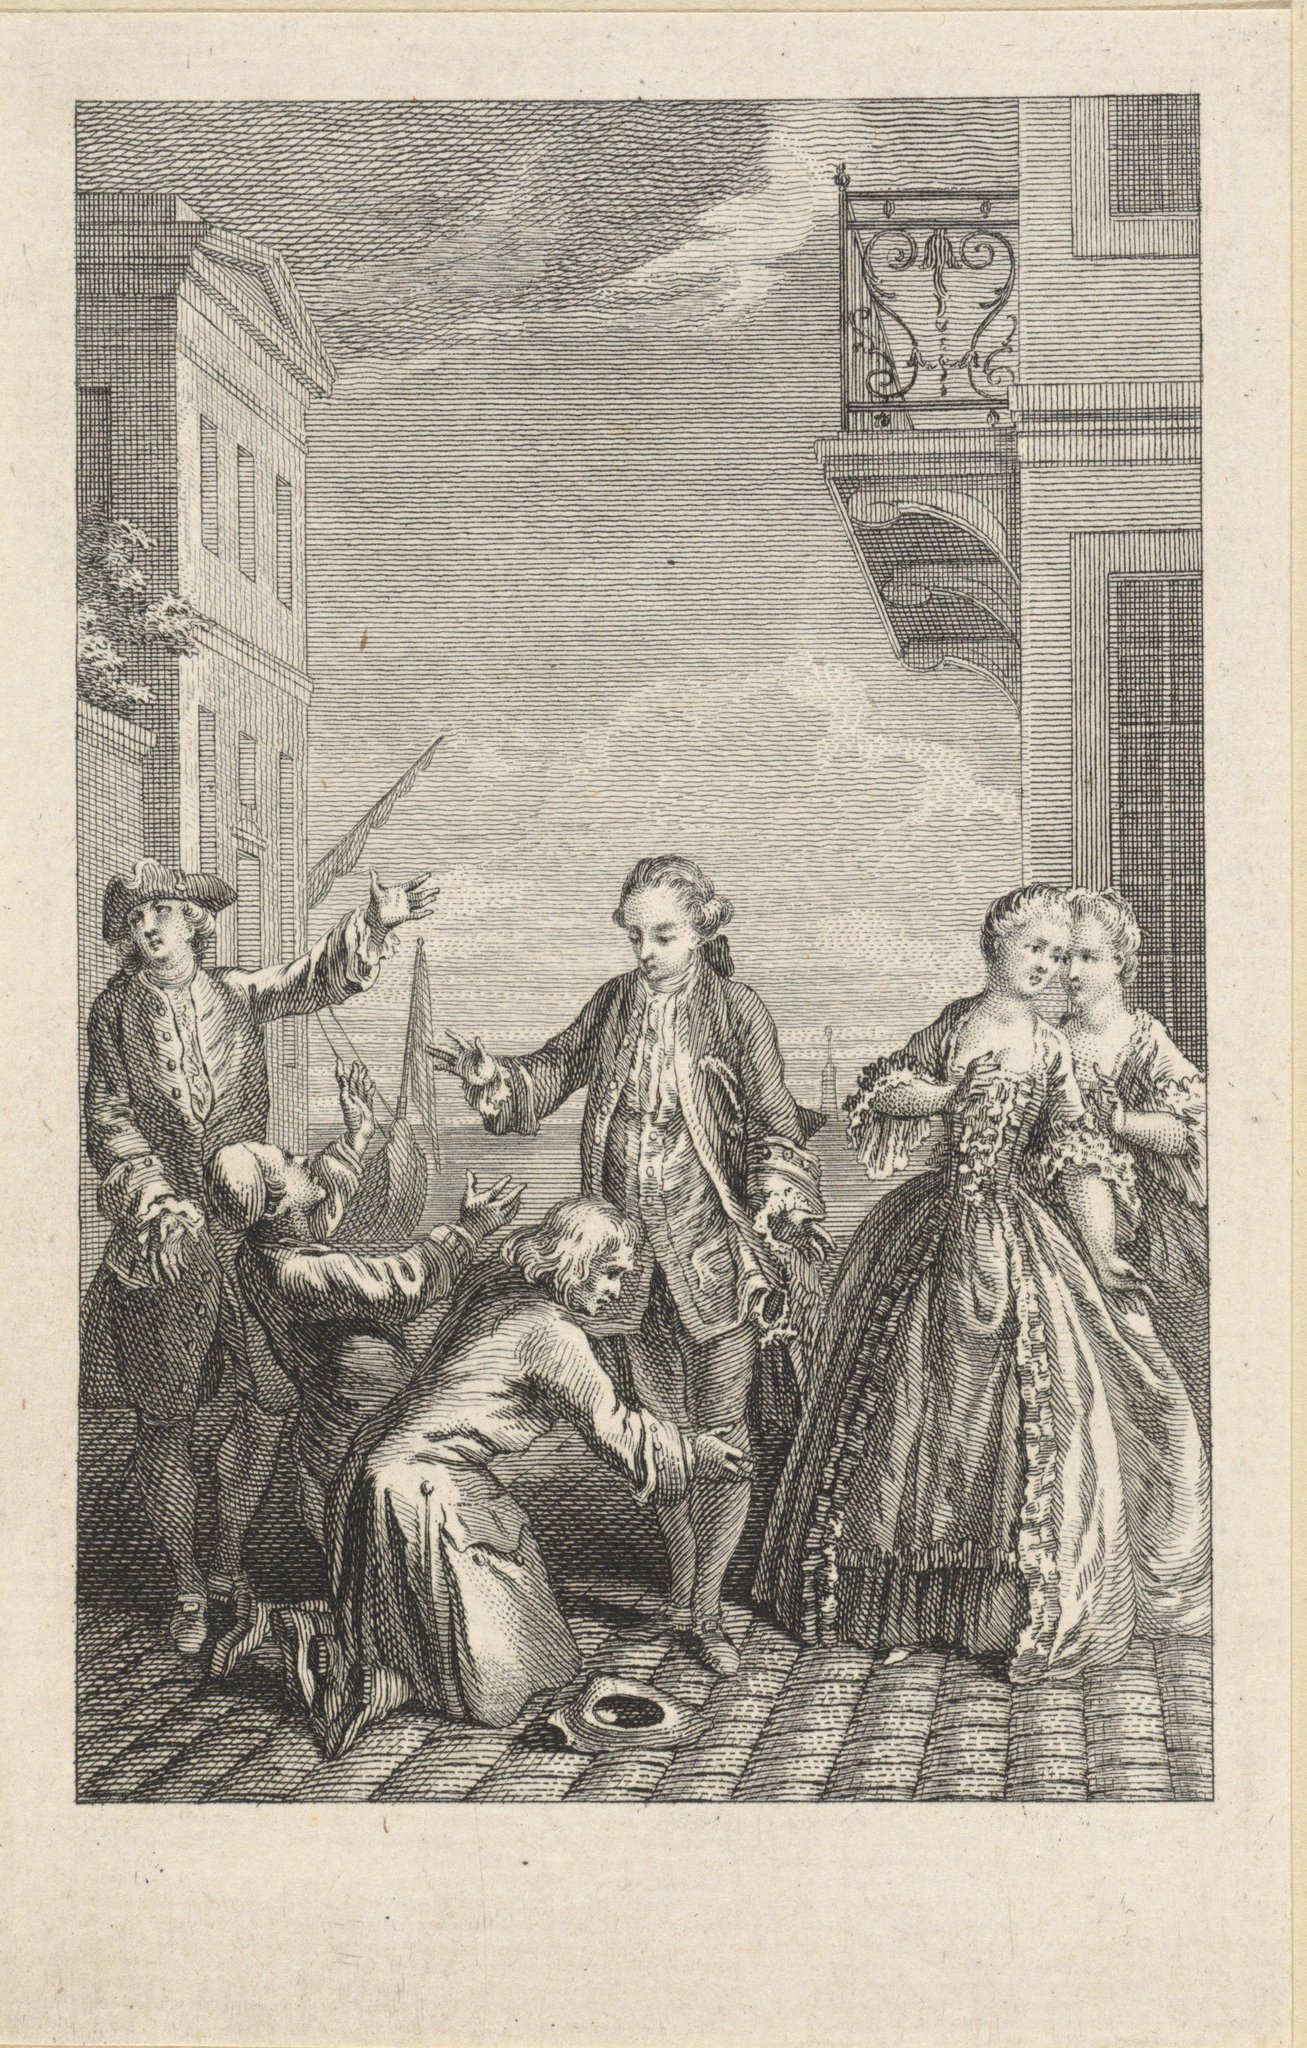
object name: print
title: Twee geknielde mannen op een kade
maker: reinier vinkeles (i)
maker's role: draughtsman, print maker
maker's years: 1741-1816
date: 1768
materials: paper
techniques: engraving, etching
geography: amsterdam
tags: kneeling figure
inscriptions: collector's mark: Lugt 240